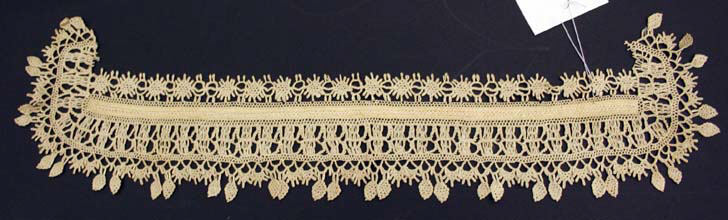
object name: collar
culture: croatian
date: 1801-1833